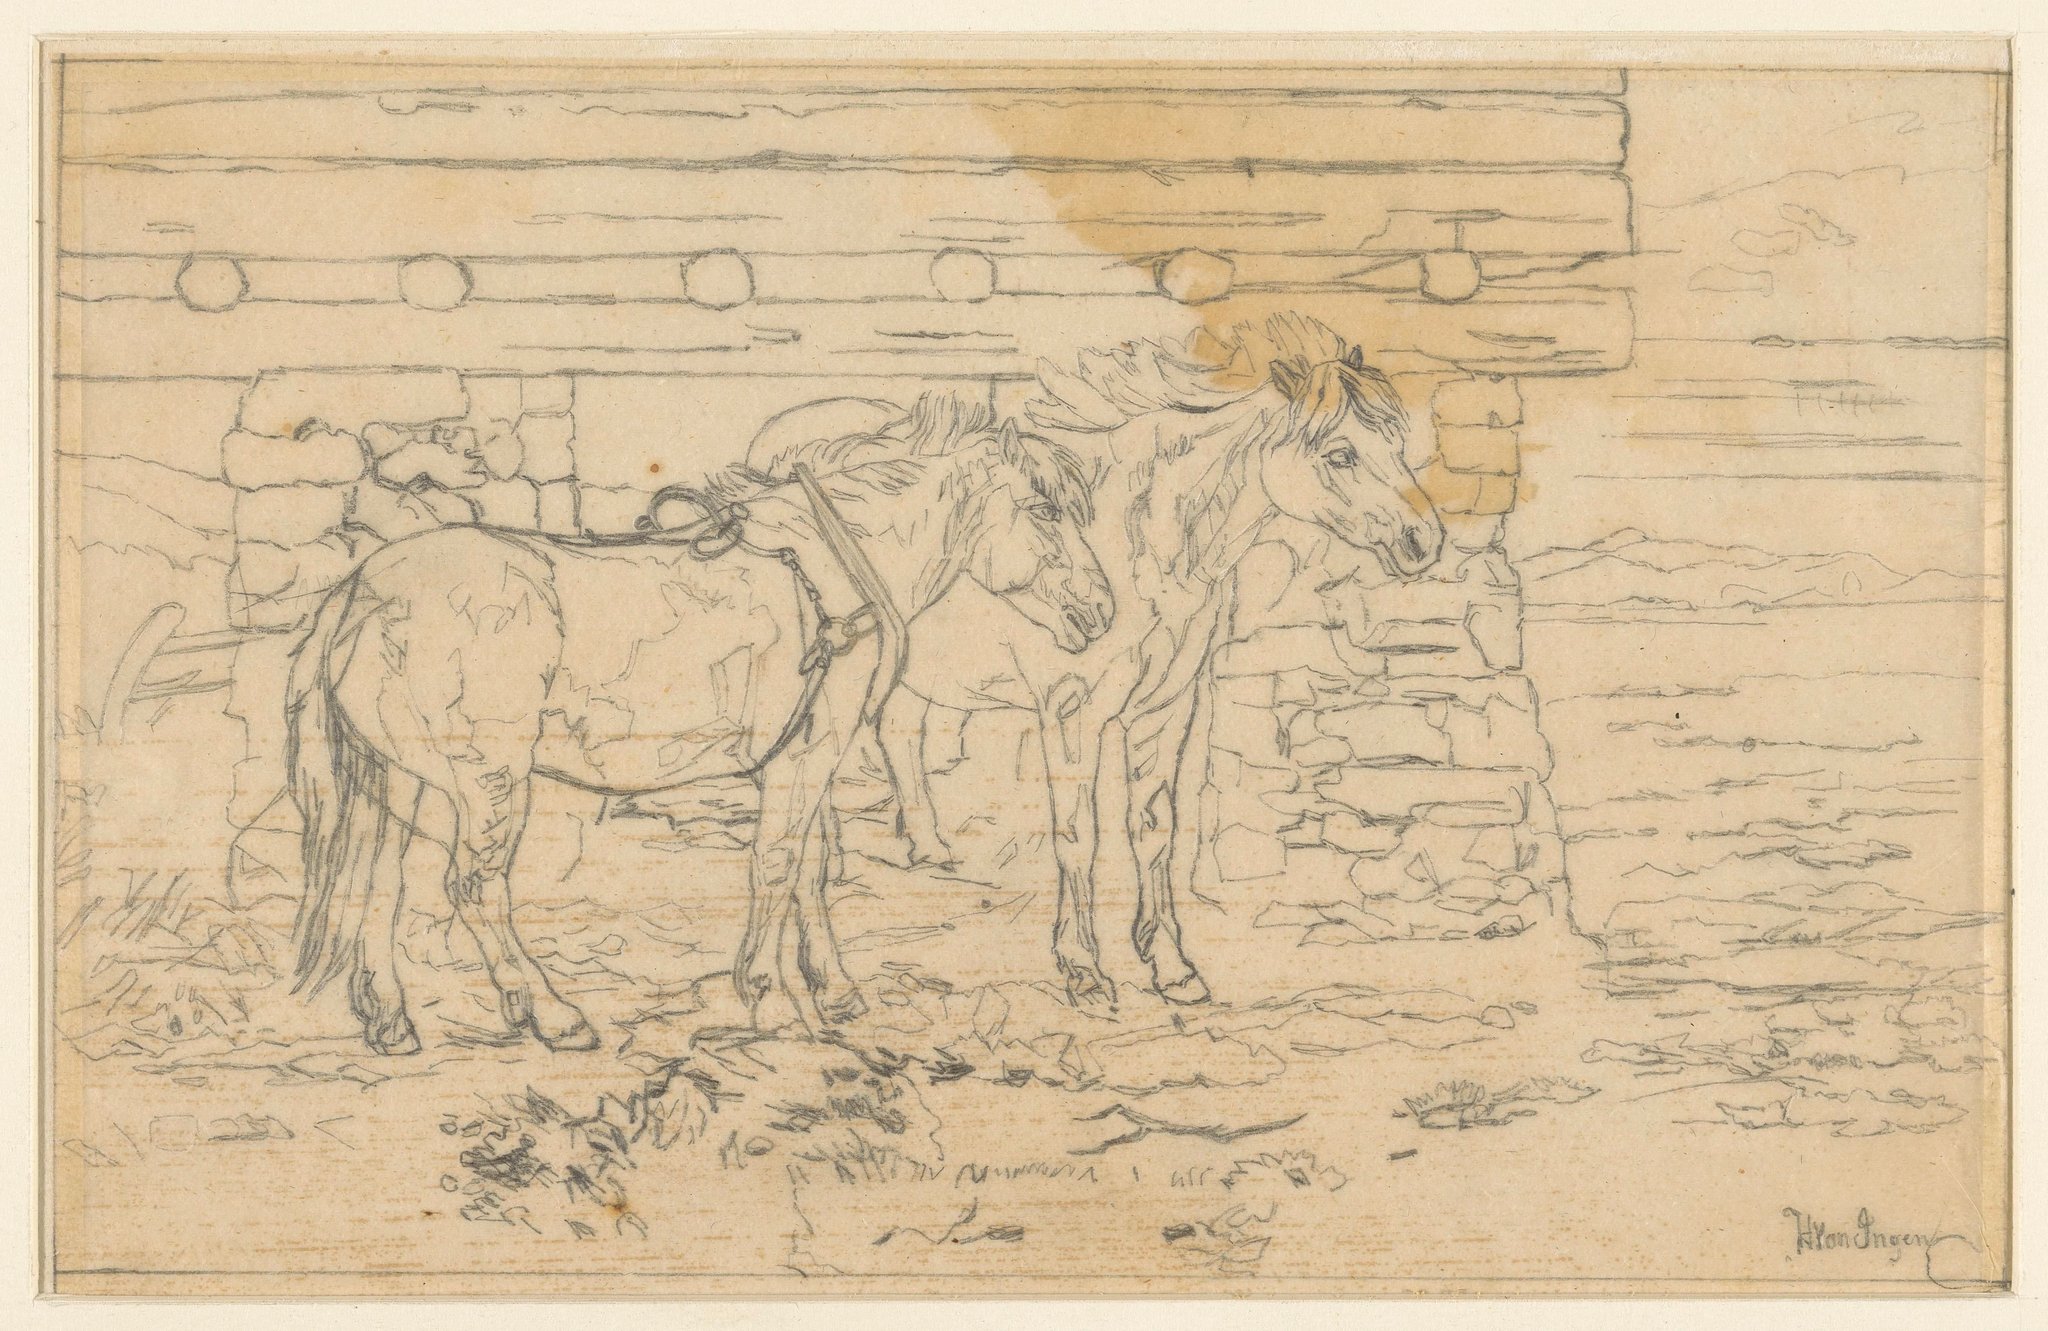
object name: drawing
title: Twee paarden voor een schuur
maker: frederik hendrik weissenbruch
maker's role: draughtsman, print maker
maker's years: 1828-1887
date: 1838-1887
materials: pencil, paper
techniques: pouncing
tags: horse